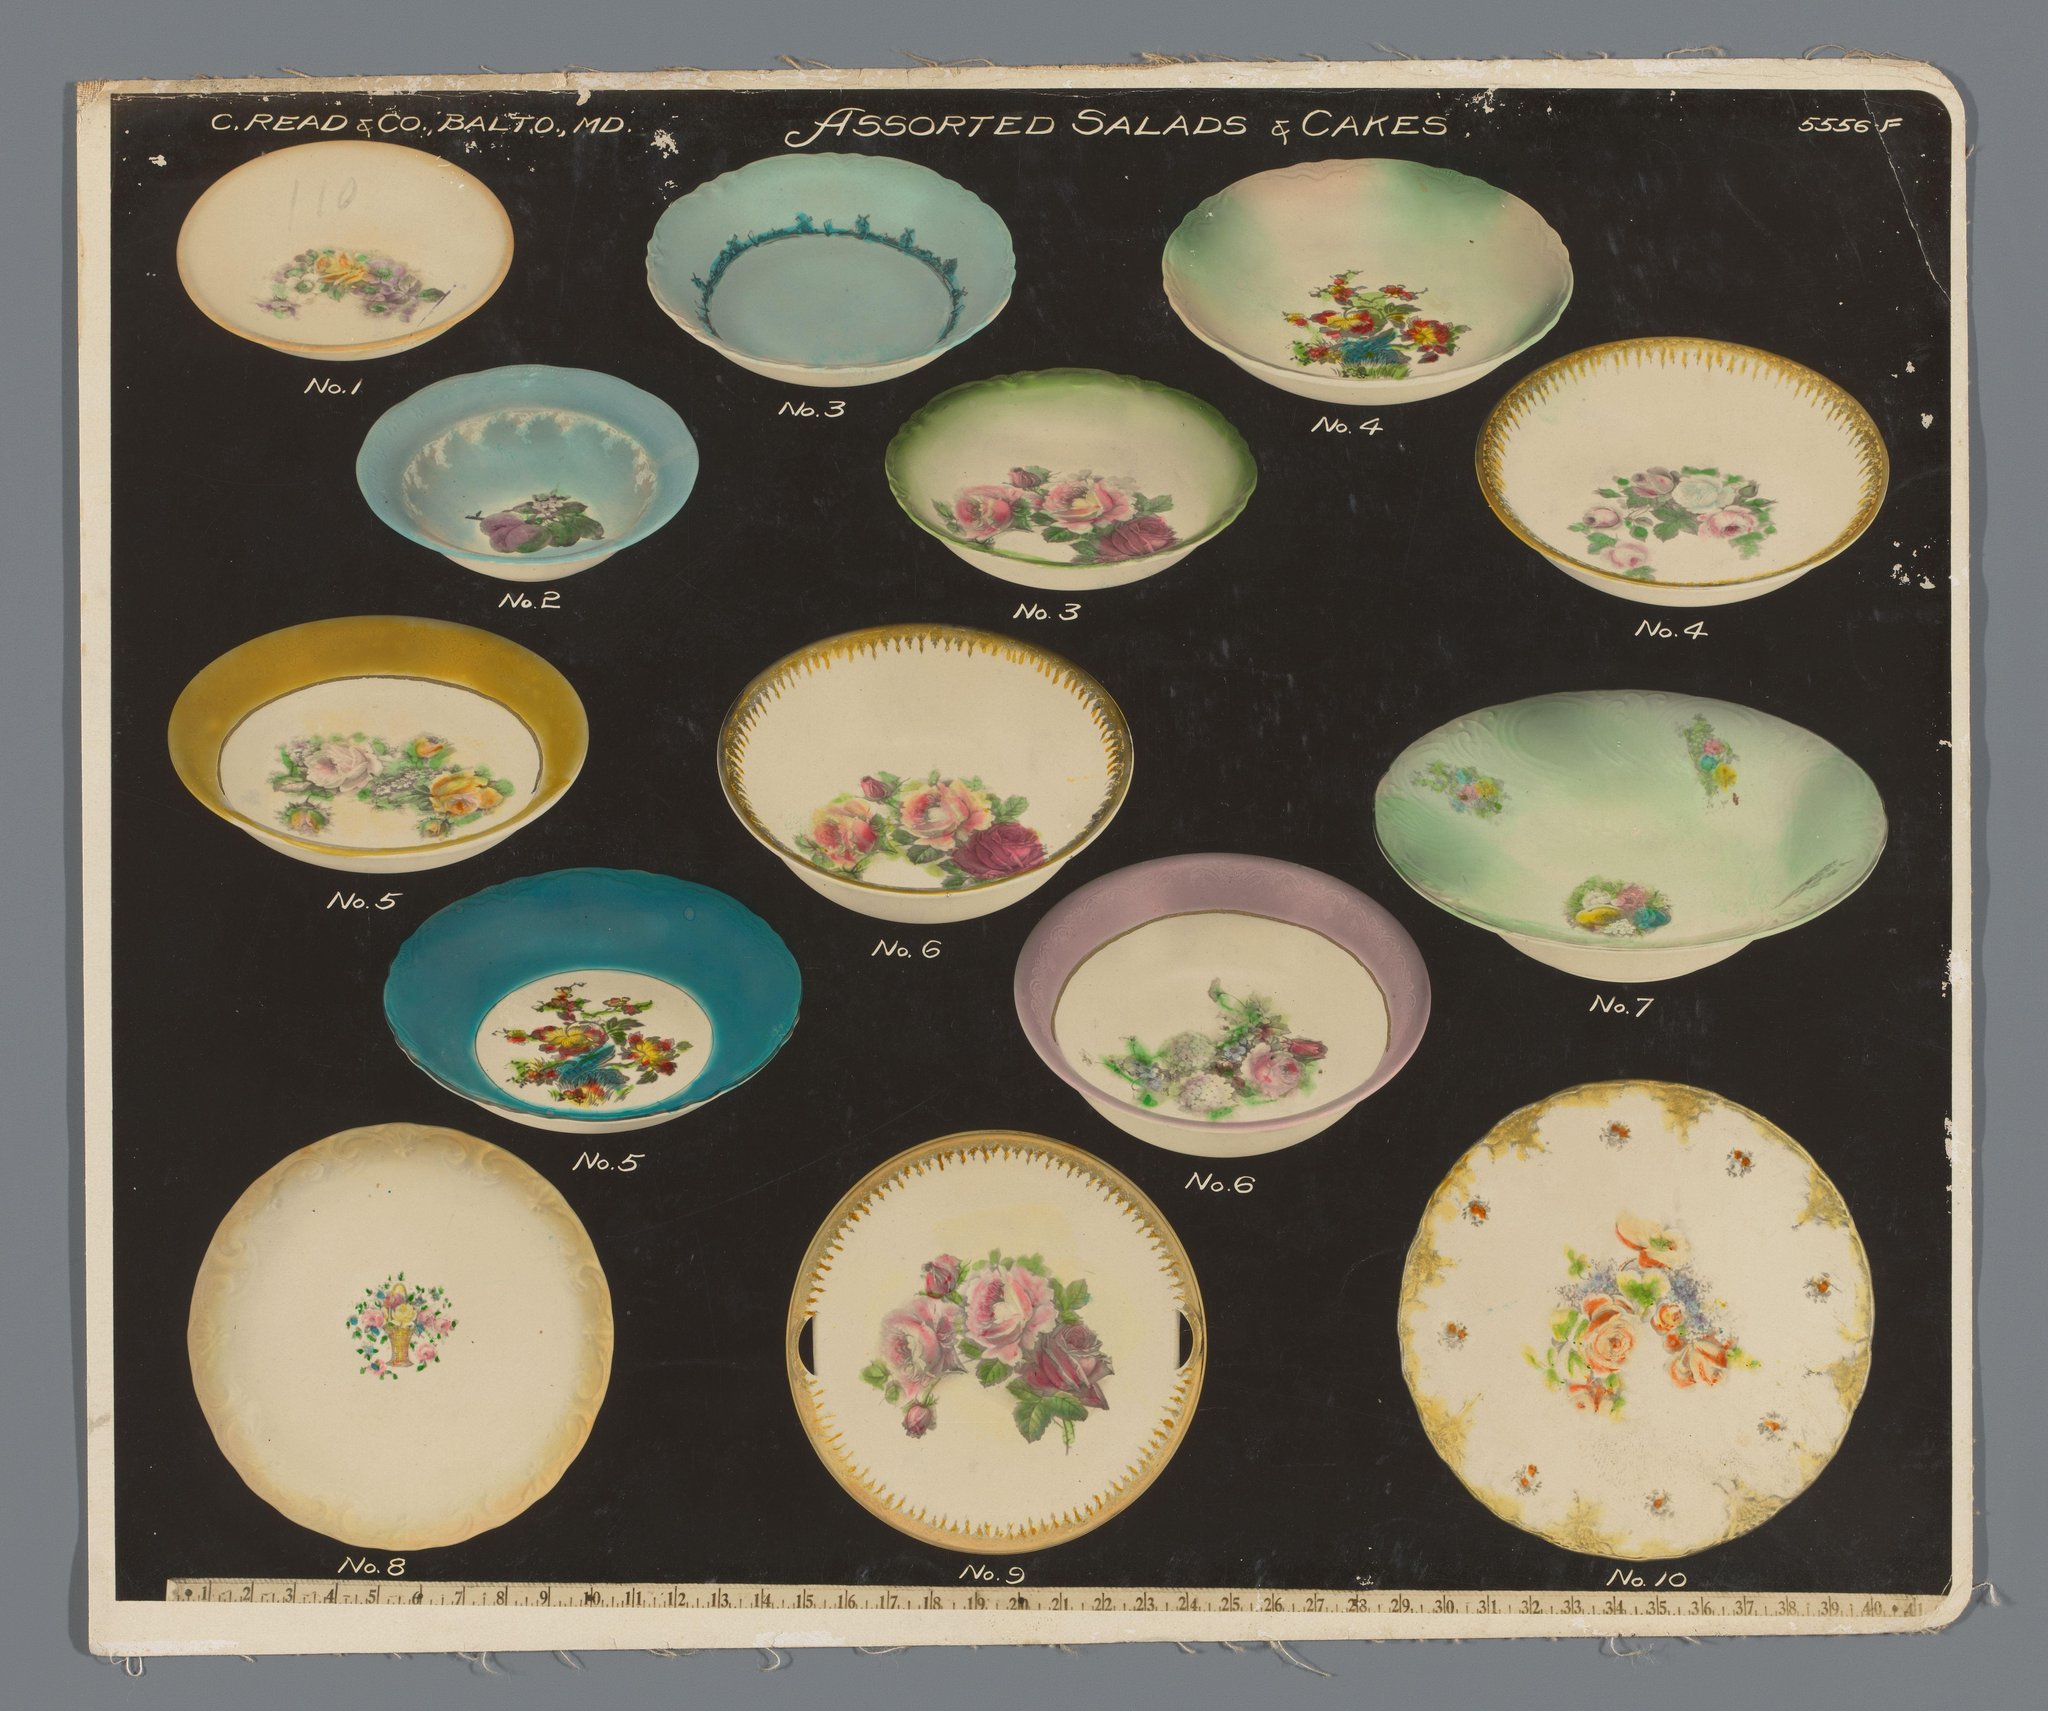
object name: photograph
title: Reclamefoto met serviezen en keukengerei van de firma C. Read & Co., Baltimore, Maryland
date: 1920-1930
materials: paper, textile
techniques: photography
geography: united states